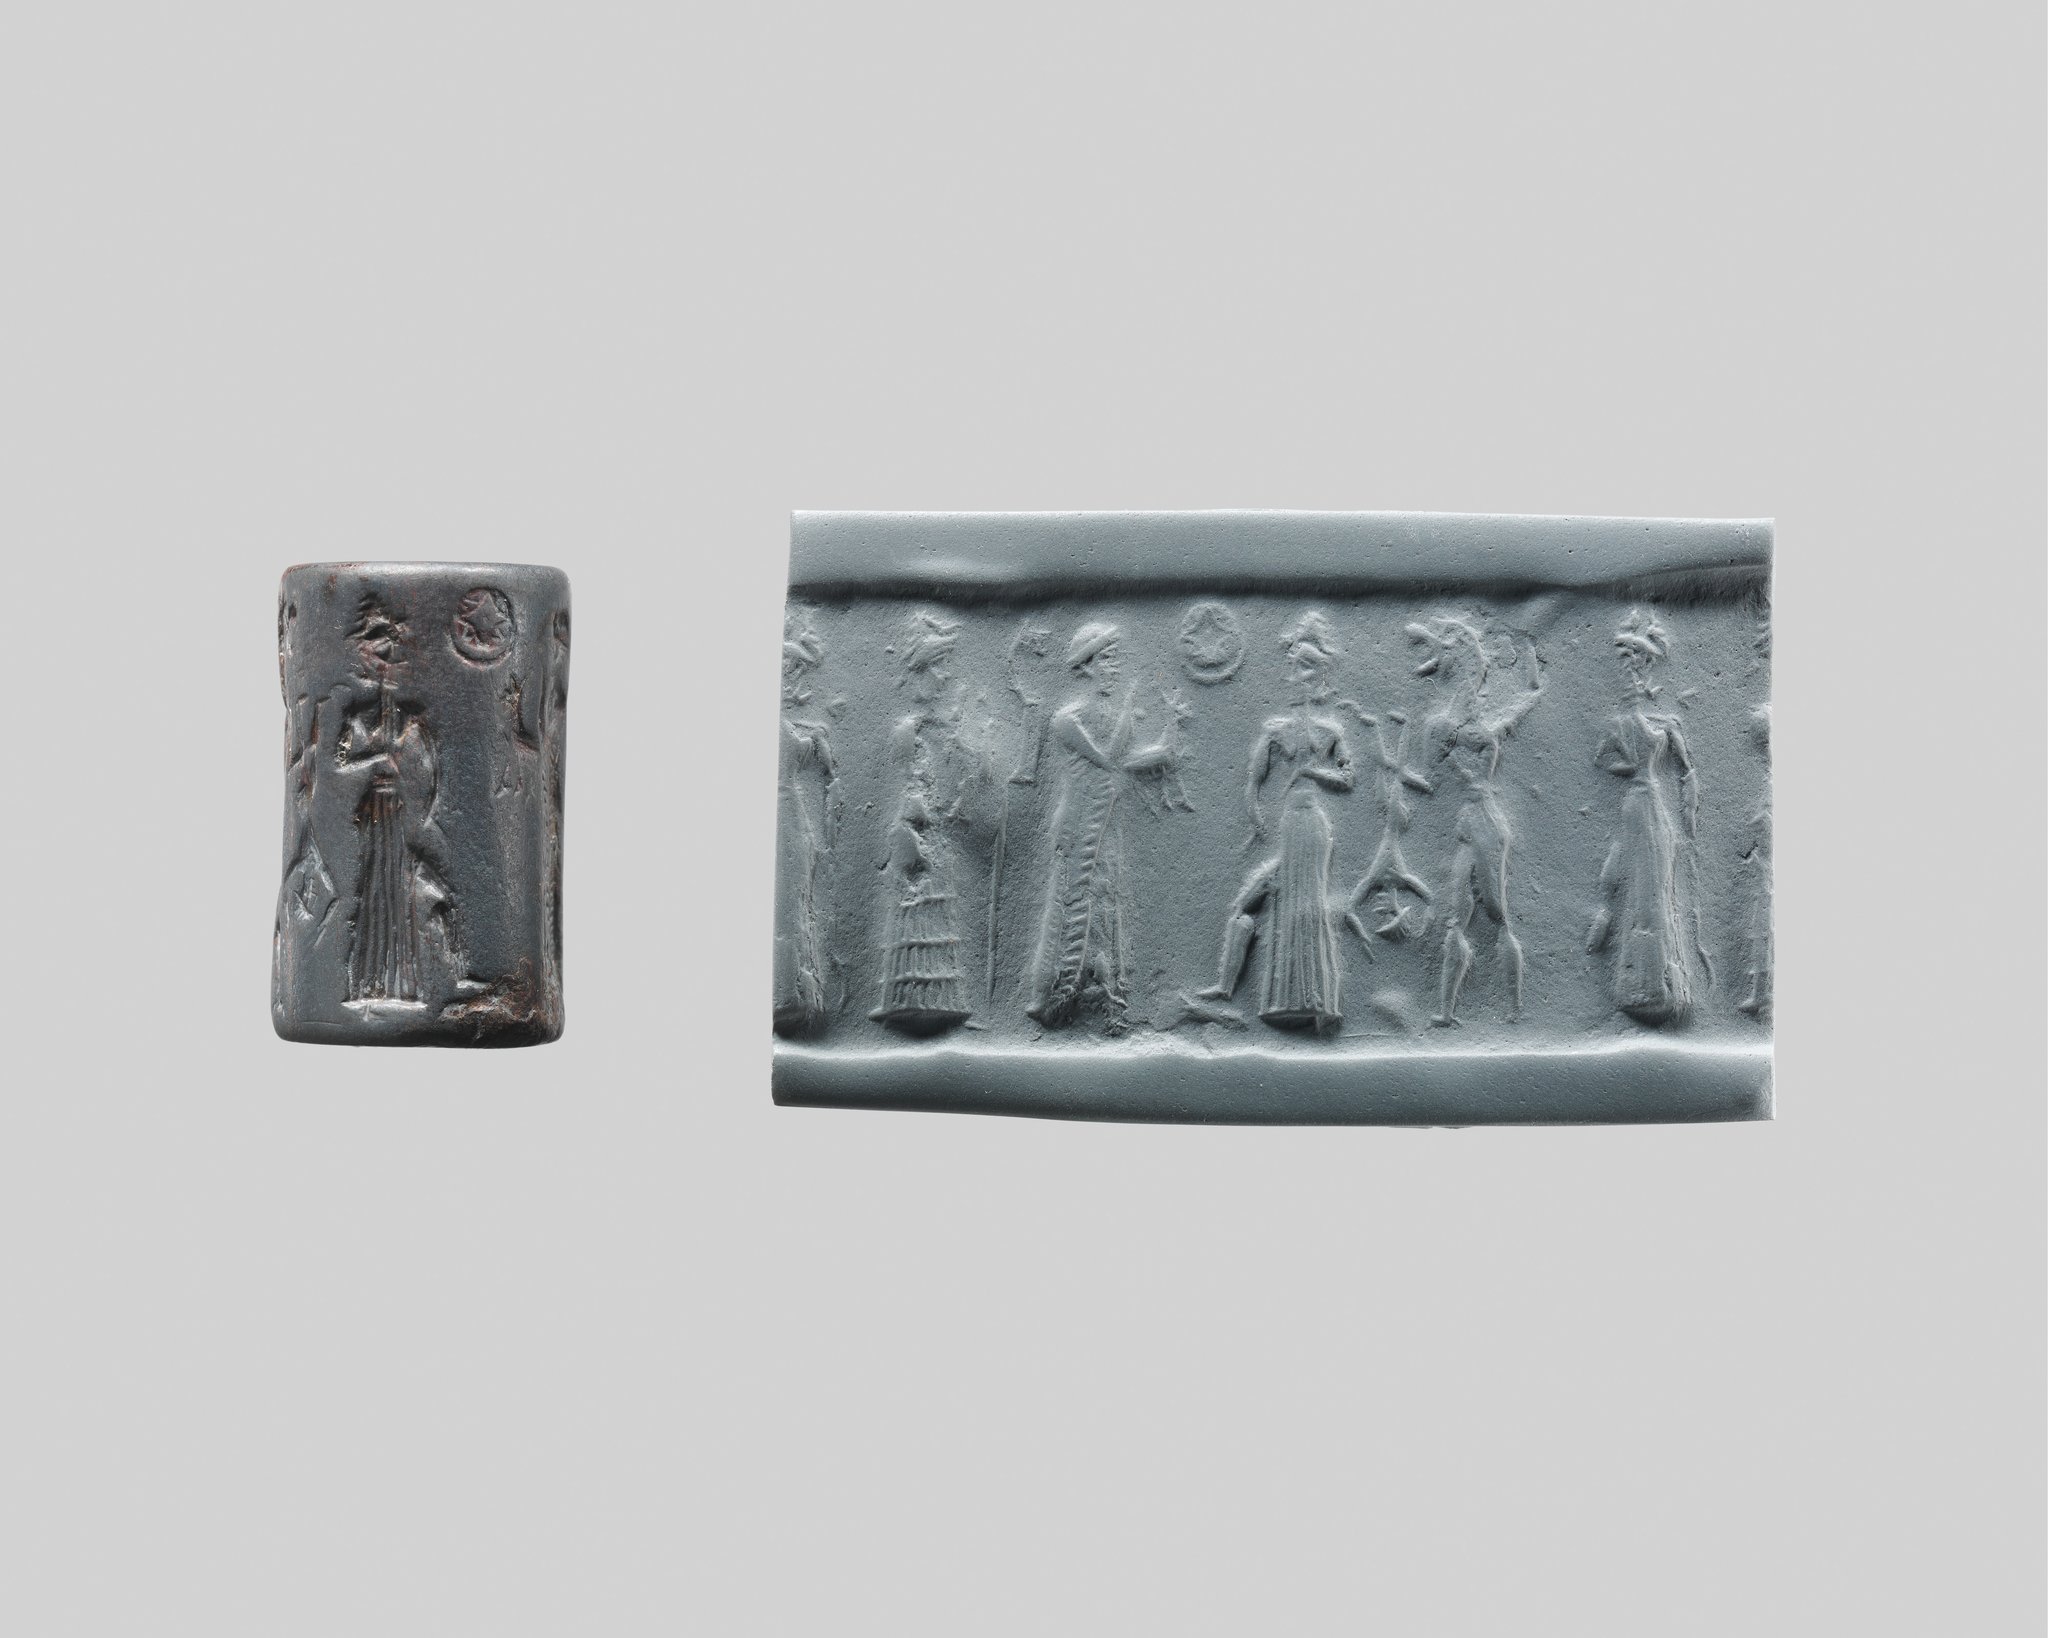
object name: cylinder seal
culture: babylonian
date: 1900-1501 BCE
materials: mineral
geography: mesopotamia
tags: animals